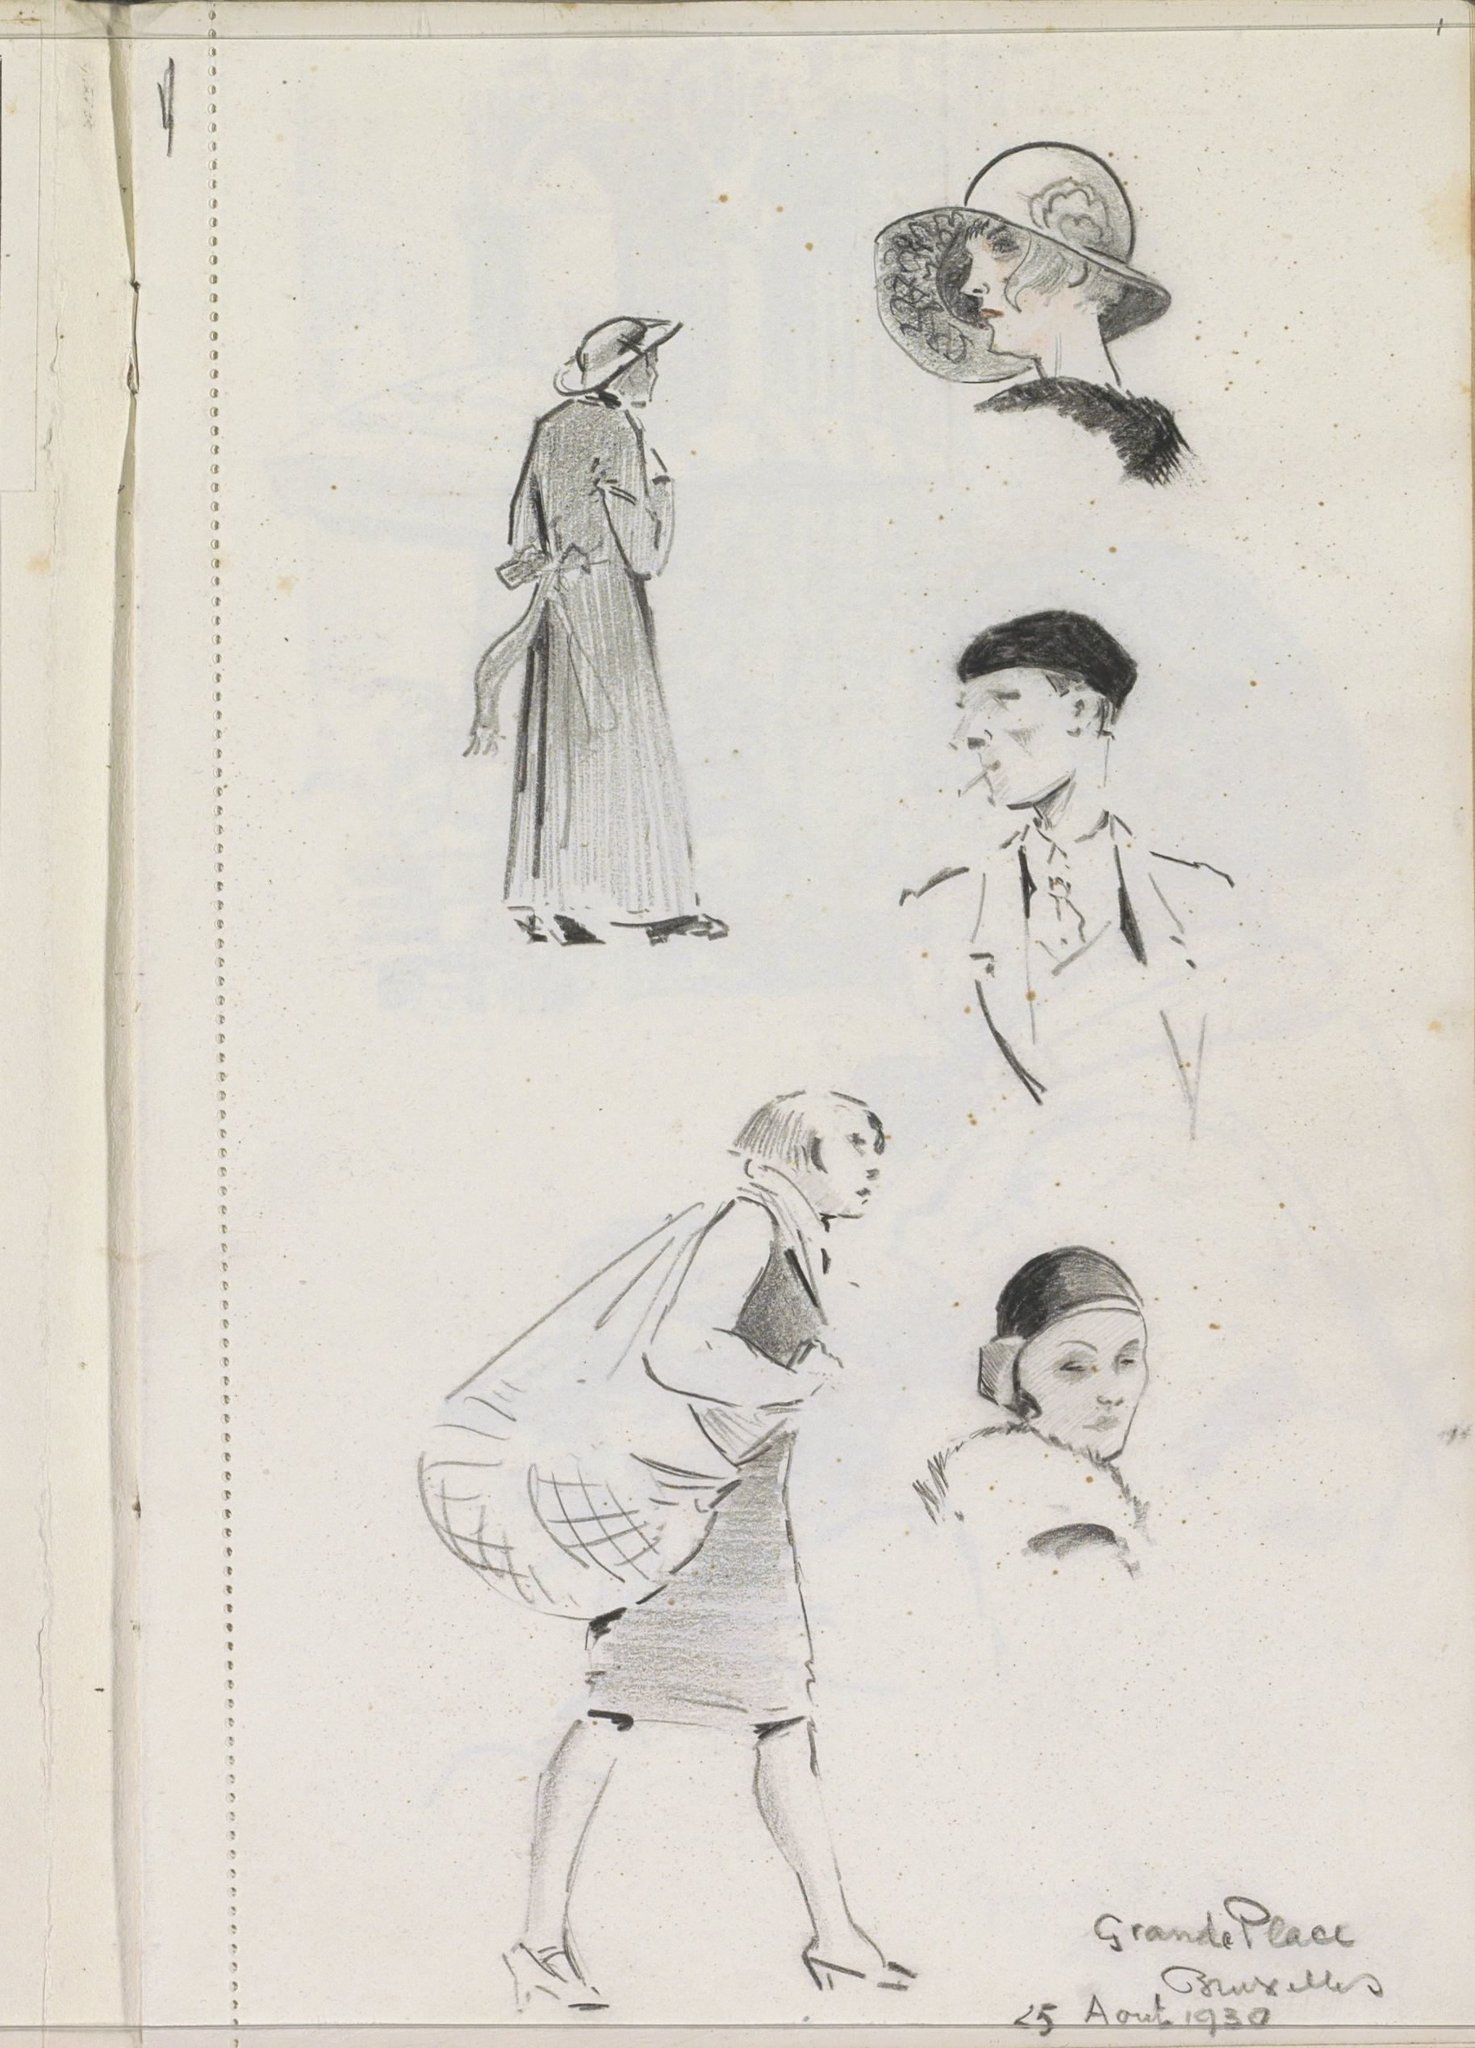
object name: sketchbook leaf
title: Figuren op de Grote Markt te Brussel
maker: otto verhagen (i)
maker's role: draughtsman, print maker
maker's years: 1885-1951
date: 1908-1930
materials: chalk, paper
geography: brussels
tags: city dwellers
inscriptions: date and inscription: ‘Grande Place/ Bruxelles/ 25 Aout 1930’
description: Pagina 1 uit een schetsboek met 60 bladen.